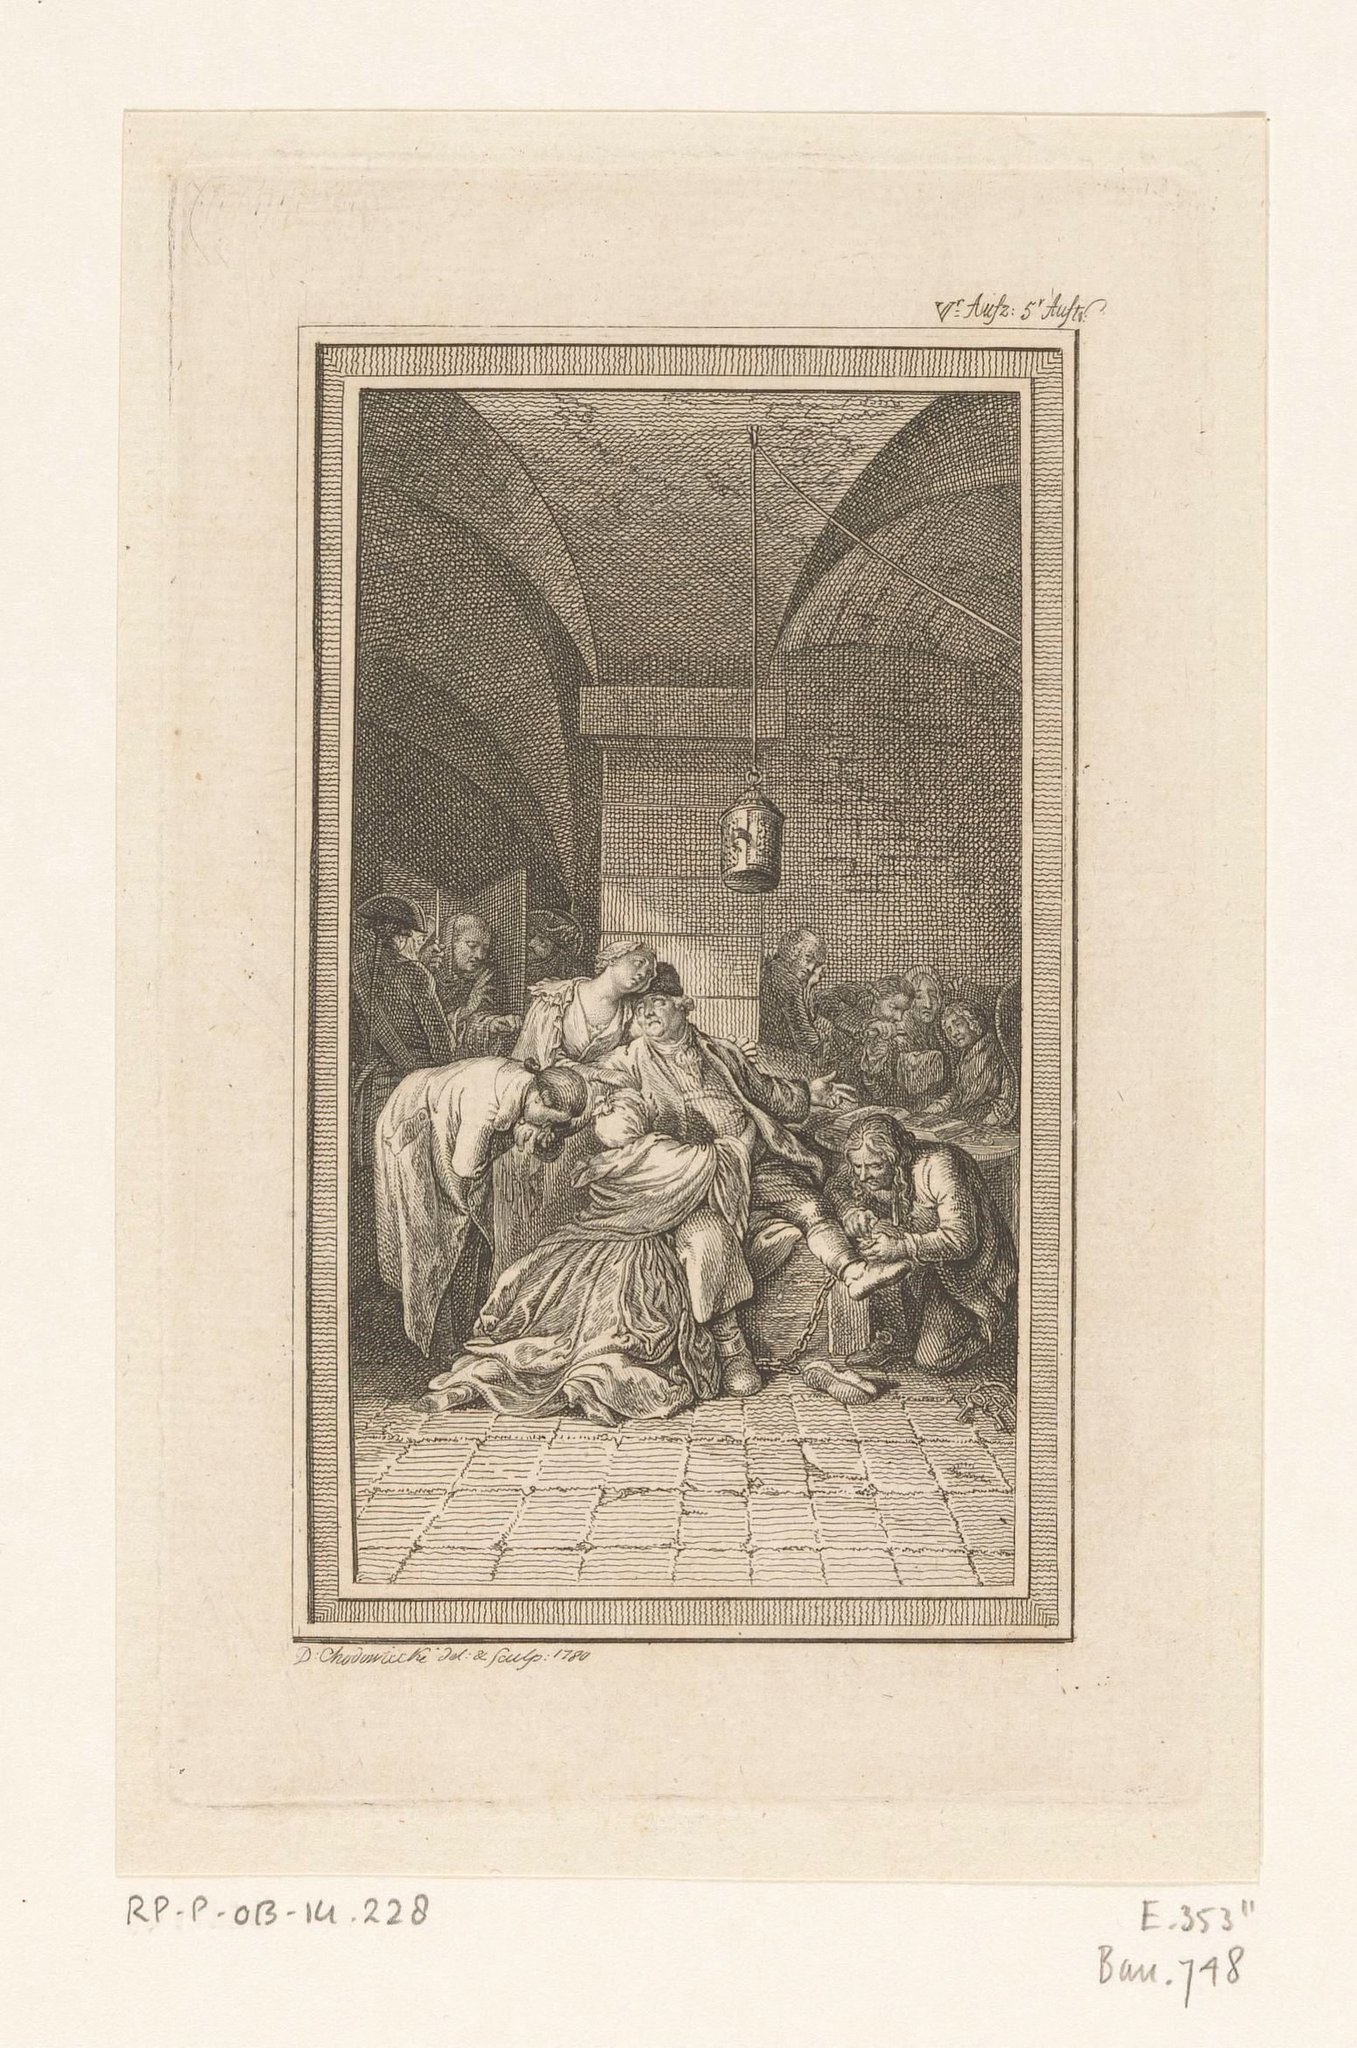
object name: print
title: Jean Calas spreekt voor de laatste keer tot zijn kinderen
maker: daniel nikolaus chodowiecki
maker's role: draughtsman, print maker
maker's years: 1726-1801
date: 1780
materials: paper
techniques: etching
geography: berlin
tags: prison, jail, key, weeping, vault ~ architecture, tools, aids, implements ~ crafts and industries: chain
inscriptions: collector's mark: Lugt 240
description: Vervaardigd voor C. F. Weisses 'Jean Calas'. Prent gebruikt voor: Trauerspiele von C. F. Weisse. Leipzig: Dykischen Buchhandlung, 1780, dl. 5.